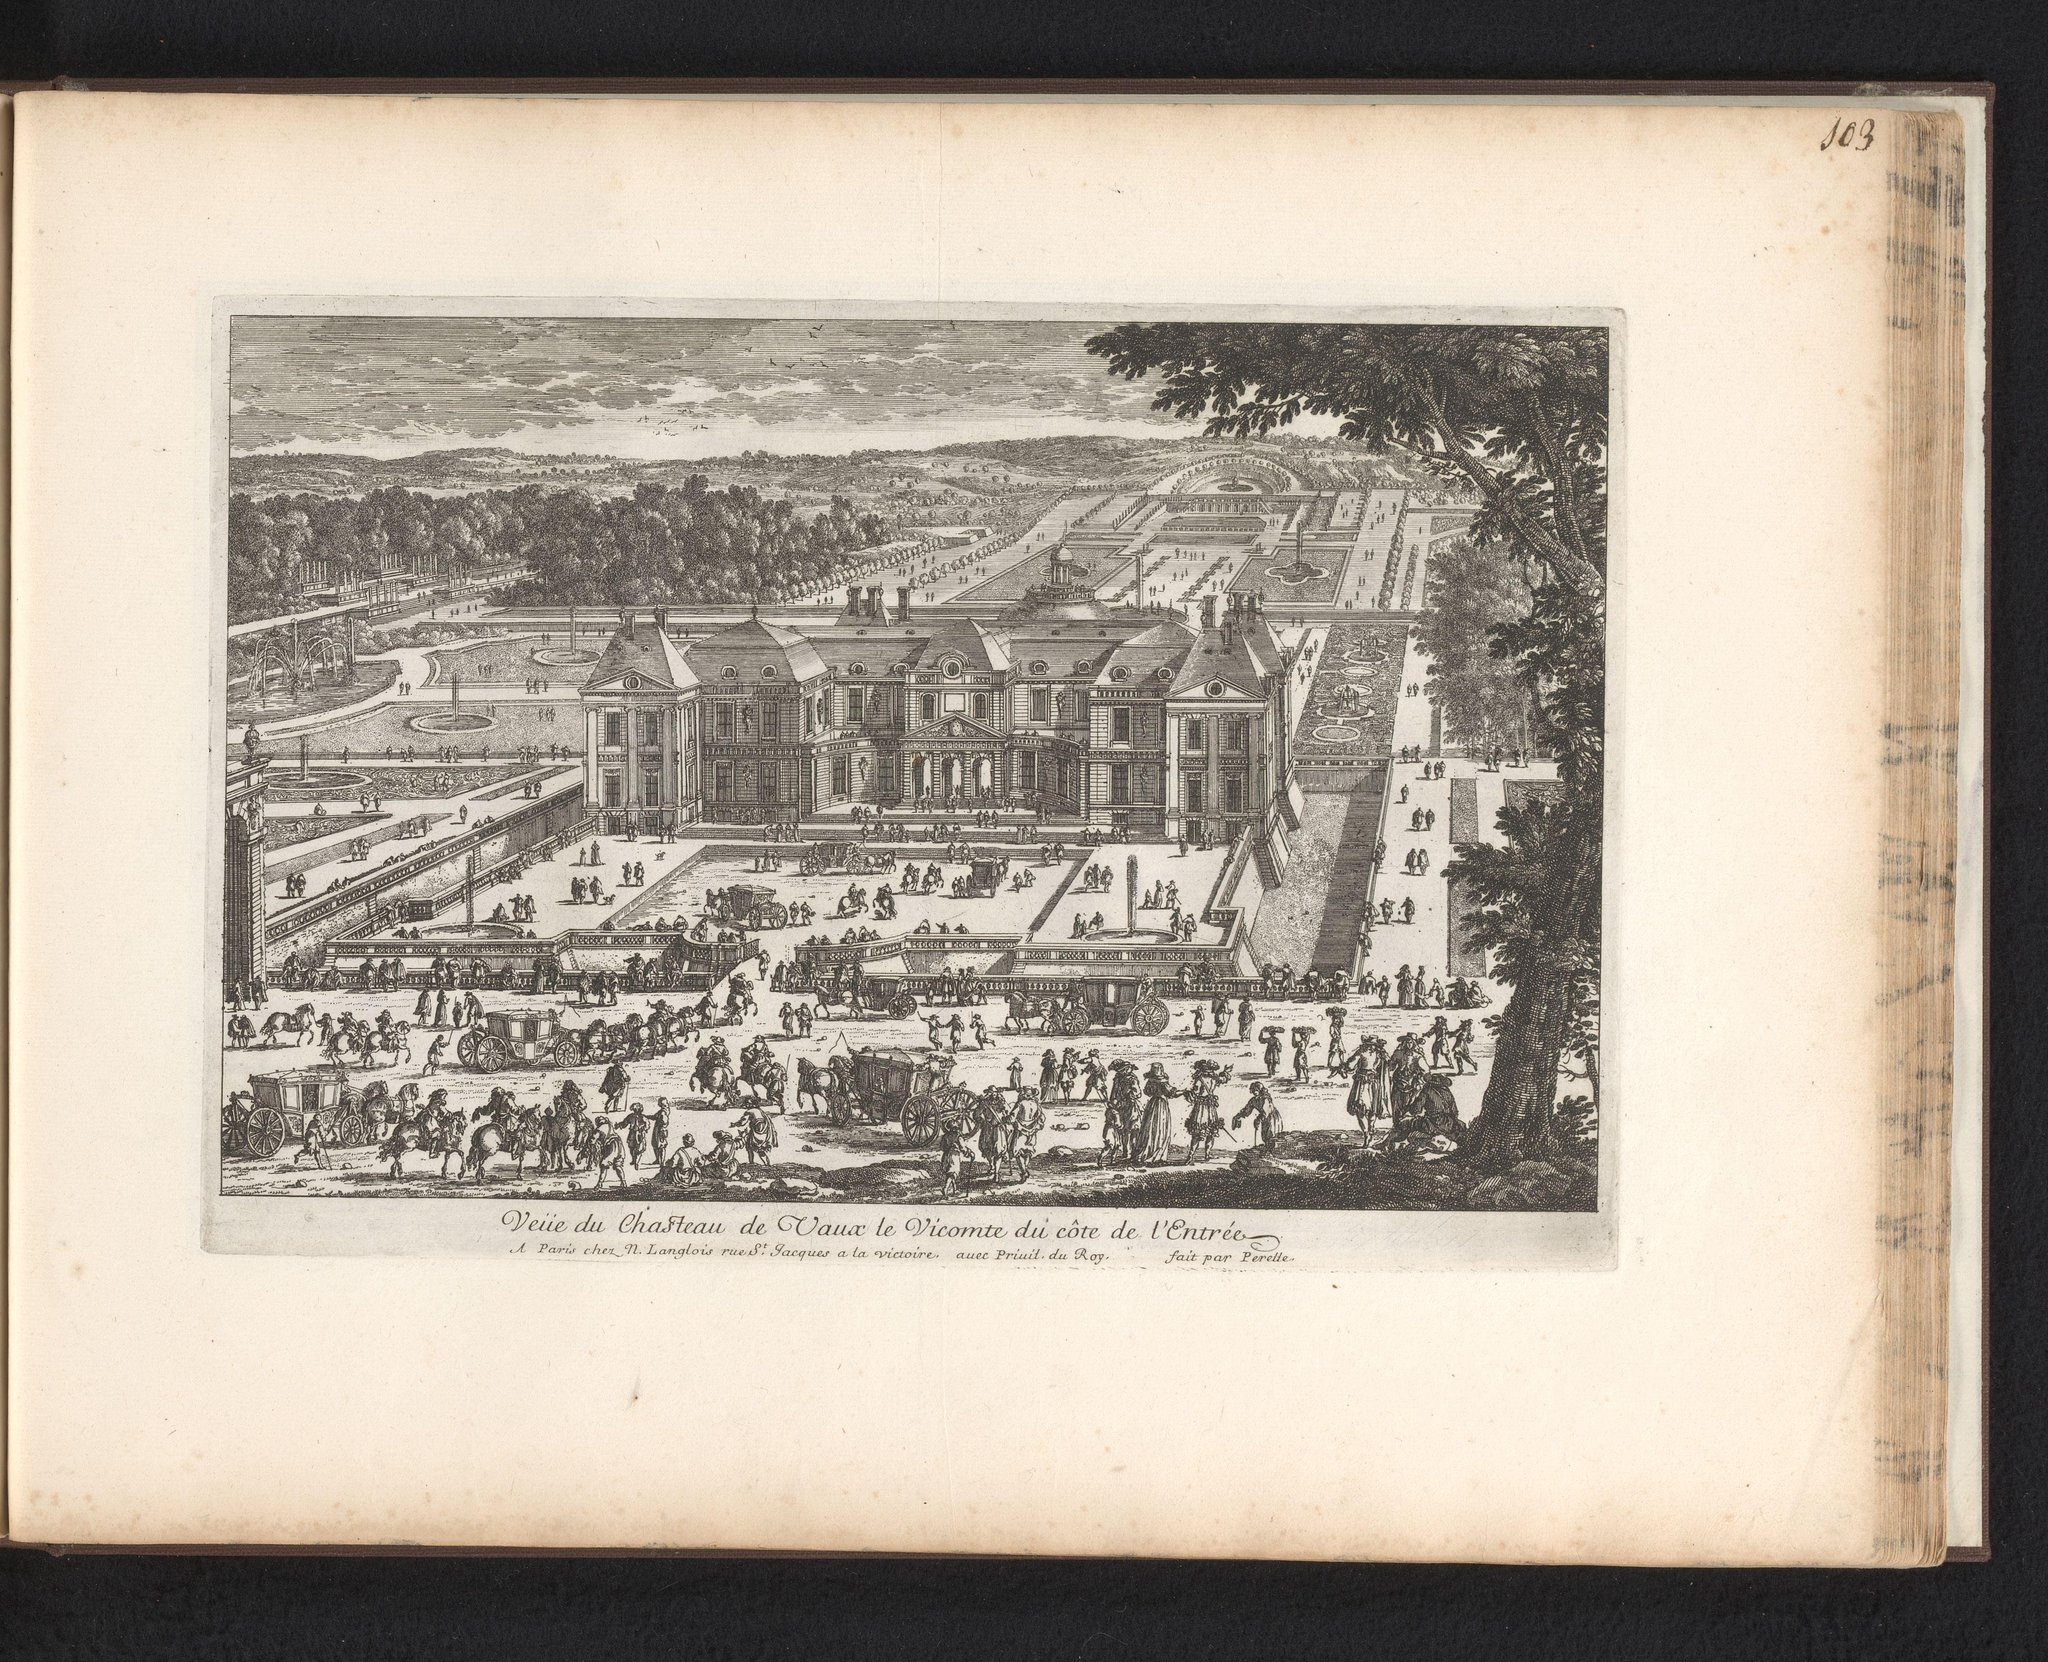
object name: album leaf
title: Stadsgezichten en landschappen in Frankrijk en Italië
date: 1660-1703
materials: paper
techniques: etching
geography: paris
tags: french or architectonic garden; formal garden, landscape with tower or castle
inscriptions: collector's mark: Lugt 2228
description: Prenten met het signatuur 'Perelle' kunnen zowel door vader Gabriel als door zonen Nicolas en Adam gemaakt zijn. De uitgevers vader en zoon Nicolas Langlois worden allebei vermeld als N. Langlois op hetzelfde adres.